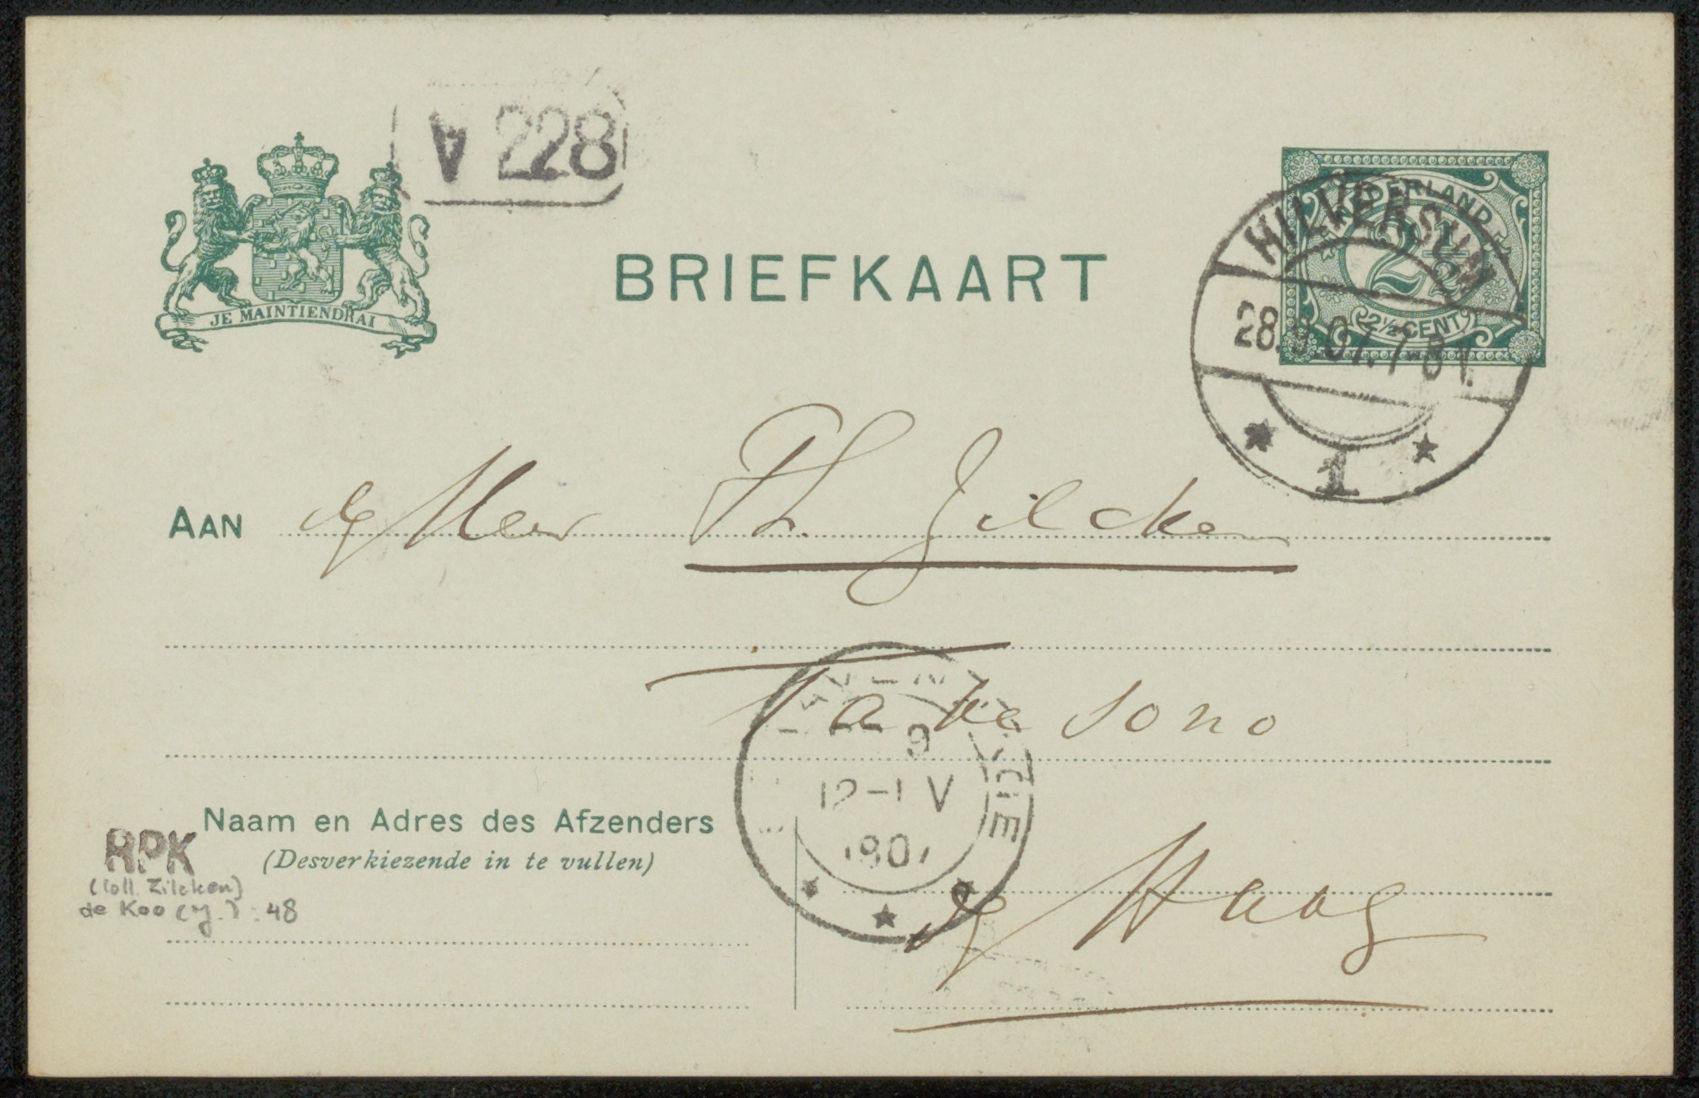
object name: postcard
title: Briefkaart aan Philip Zilcken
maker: johannes de koo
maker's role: auteur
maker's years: 1841-1909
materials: cardboard, ink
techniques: pen, writing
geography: hilversum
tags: flushing, henri pierre leonard wiessing, lodewijk van deyssel, amsterdam, painter, draughtsman, publisher, josephus albertus alberdingk thijm, the hague, philip zilcken, liège, venice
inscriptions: collector's mark: ‘RPK’